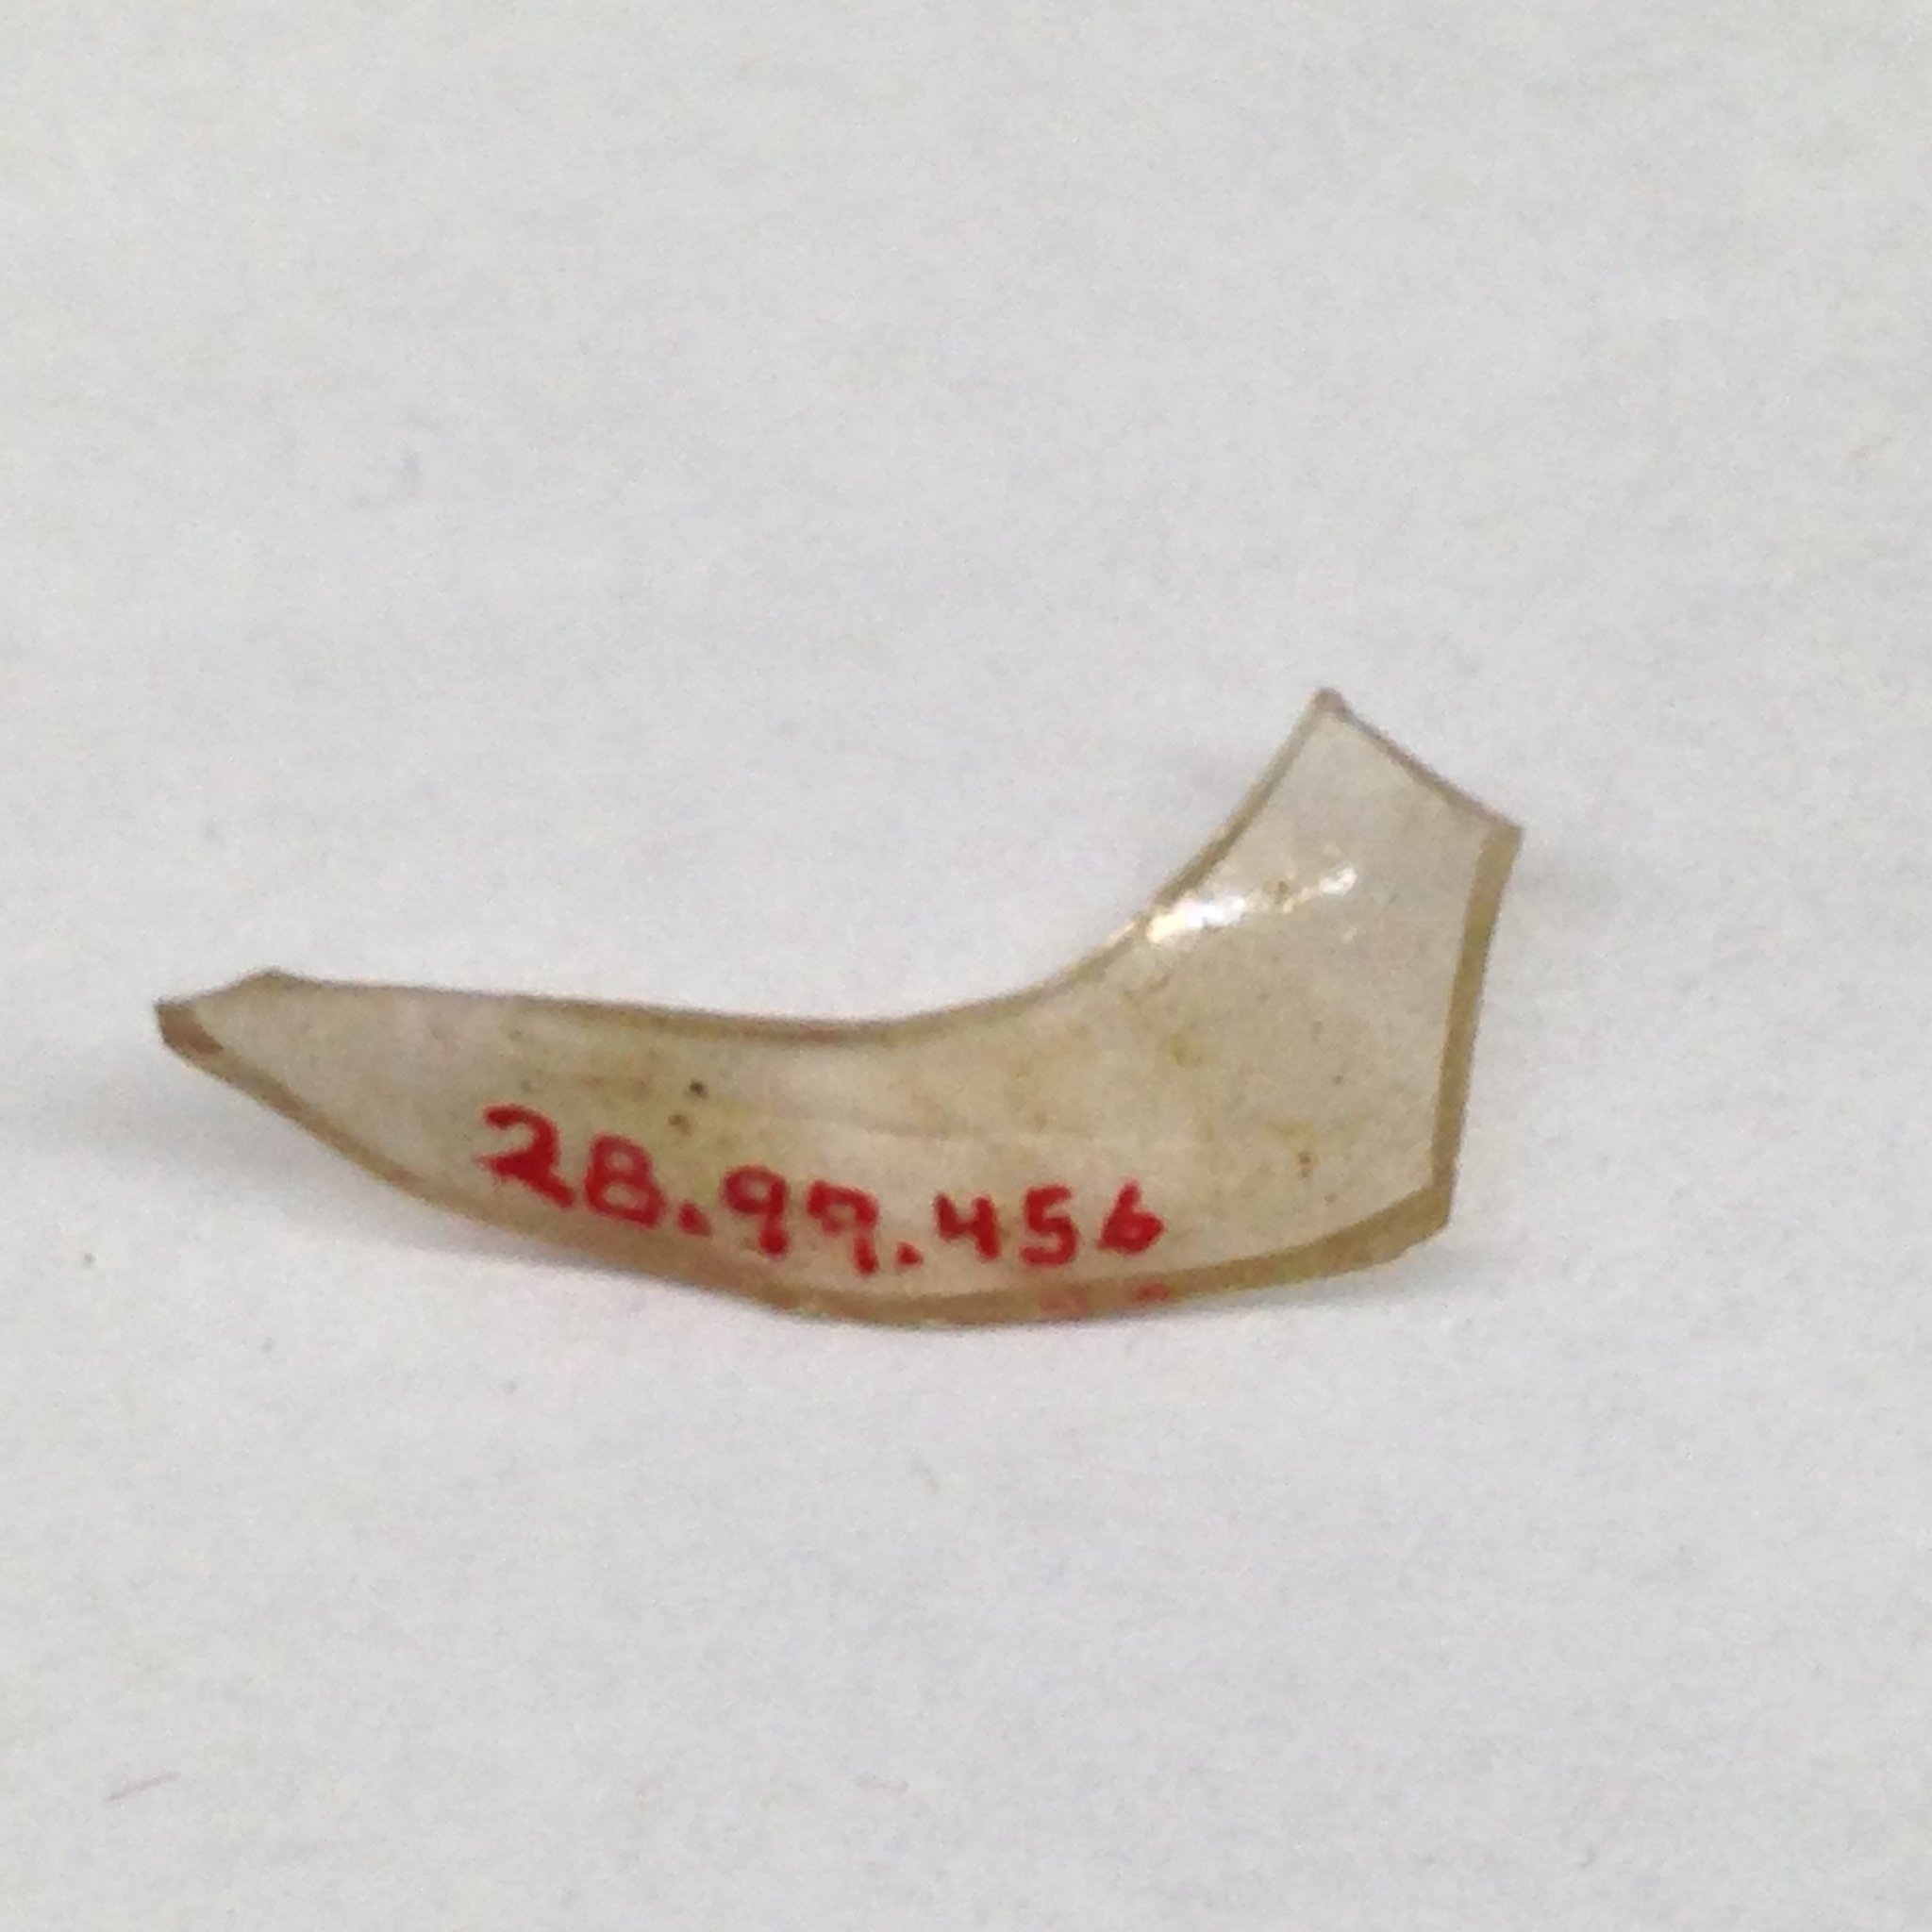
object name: fragment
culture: european or middle eastern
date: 1150-1250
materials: ceramic, glass